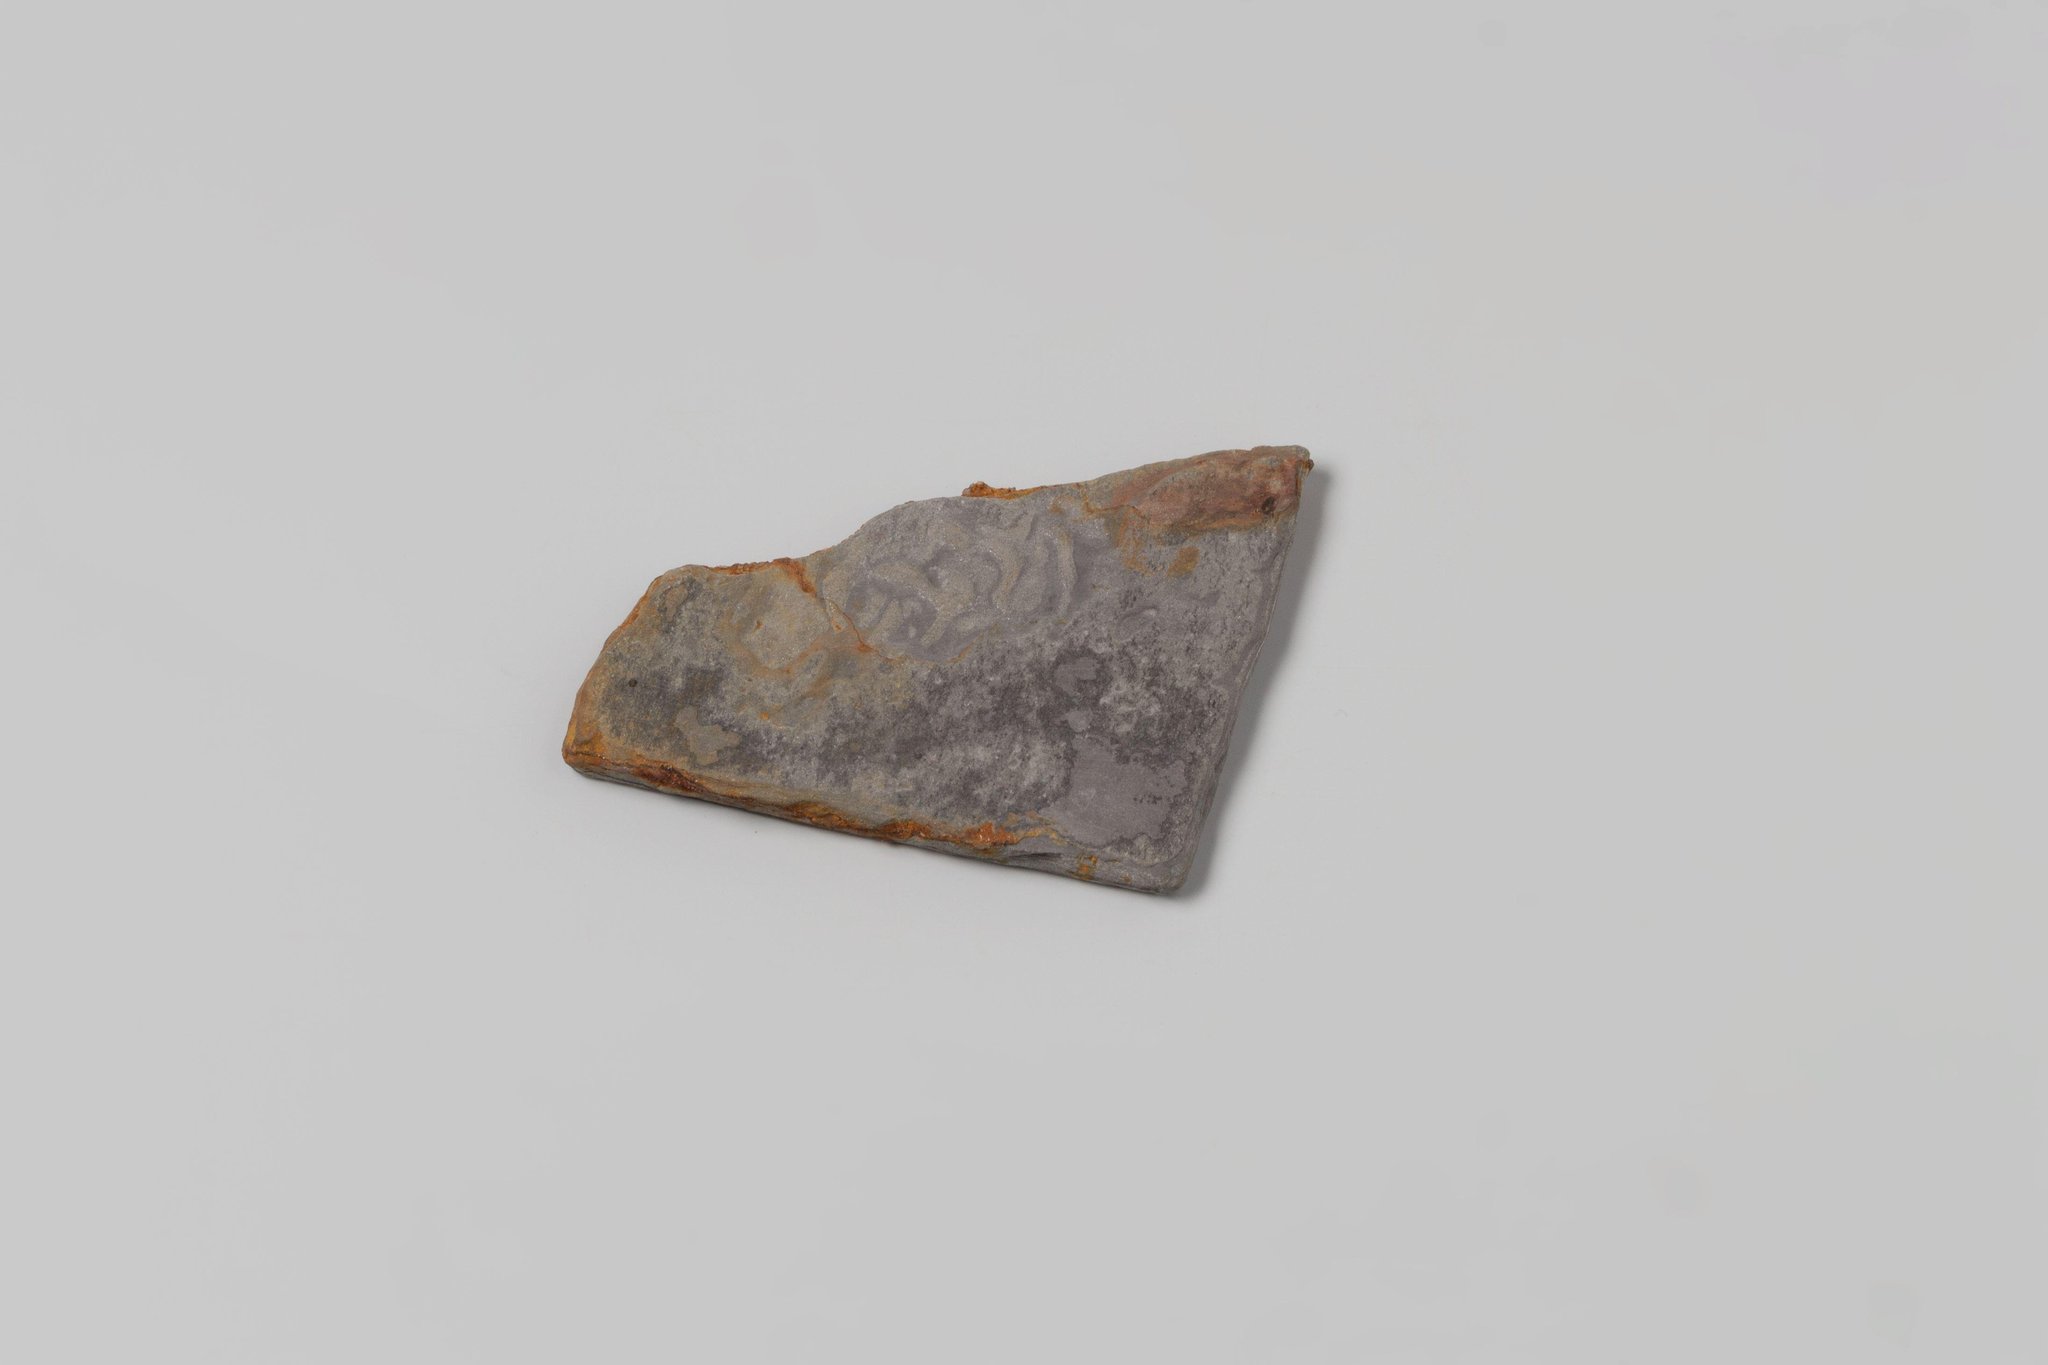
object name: scheepswrakvondst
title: Fragment leisteen uit het wrak van de Oost-Indiëvaarder Hollandia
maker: Anonymous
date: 1700-1743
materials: stone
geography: netherlands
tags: verenigde oostindische compagnie, hollandia (schip), annet